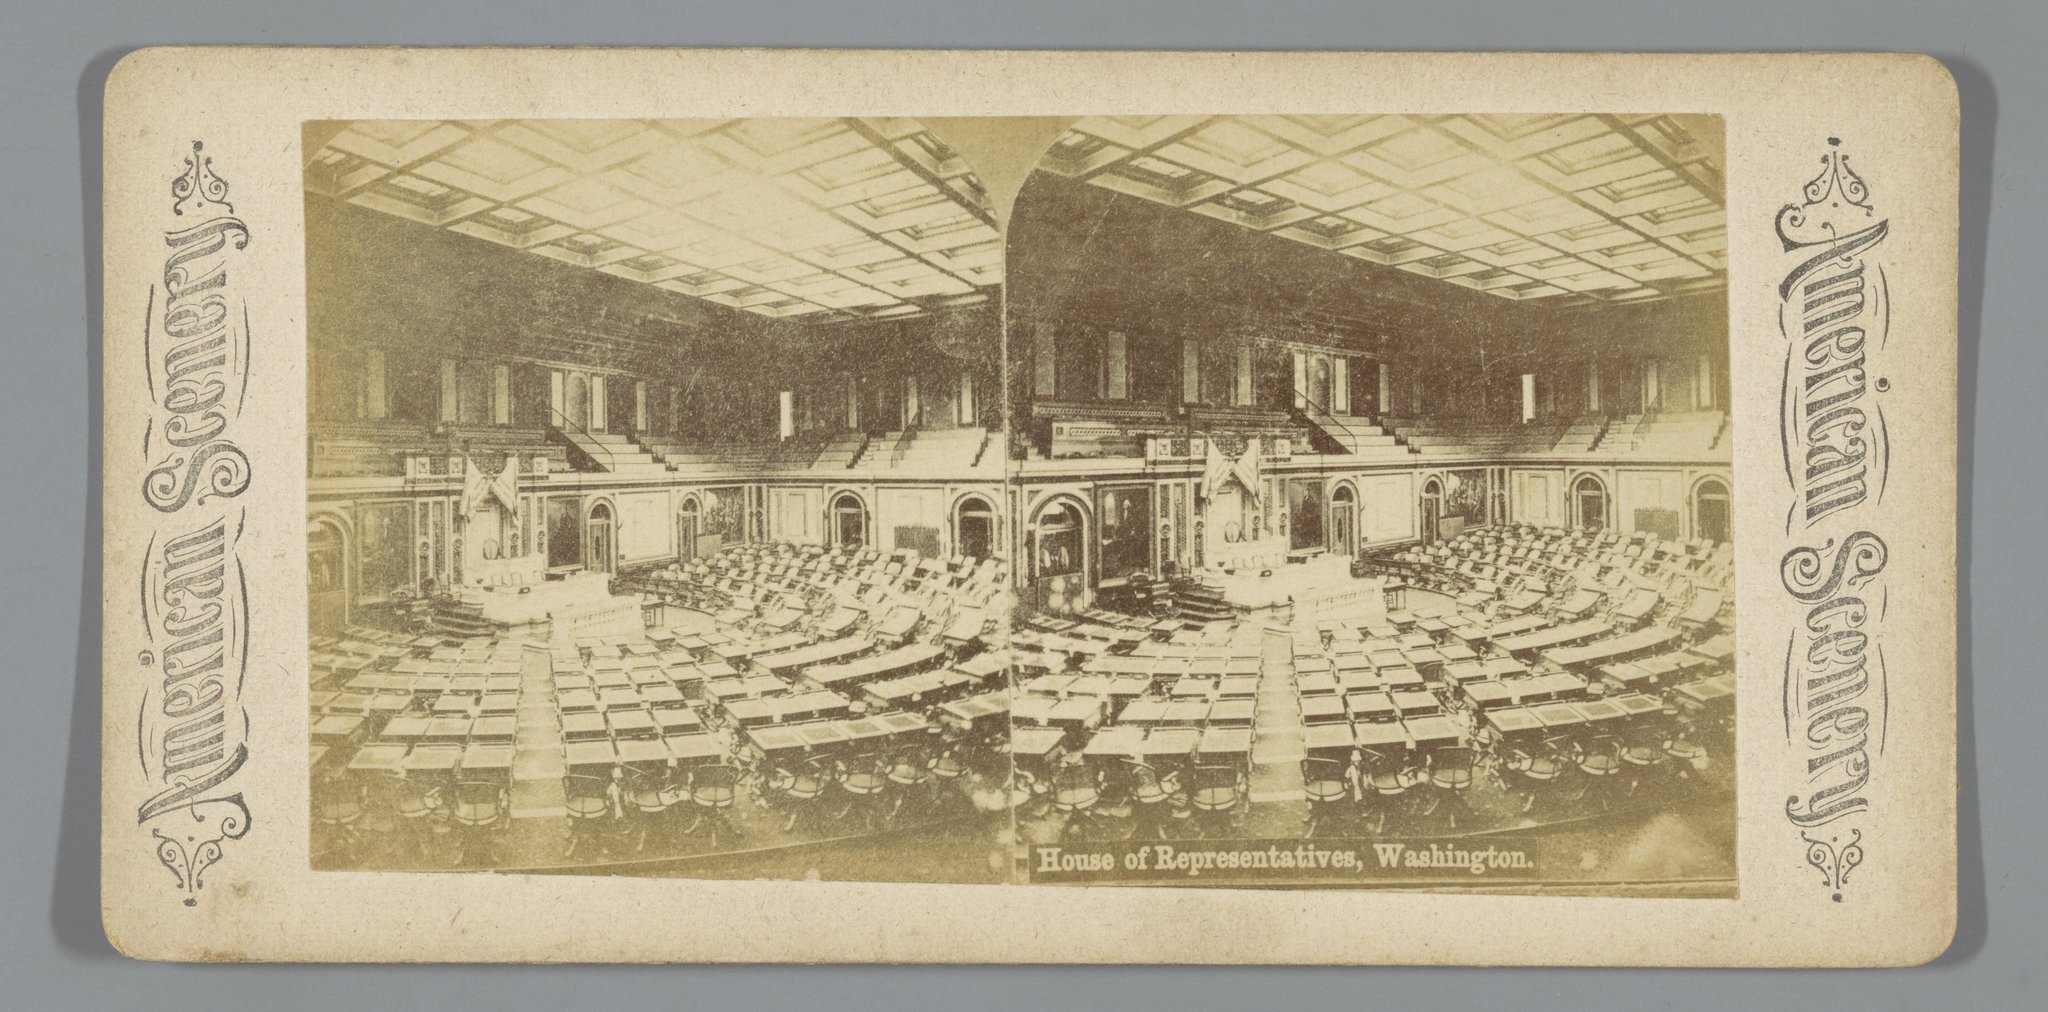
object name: stereograph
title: American Scenery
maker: Anonymous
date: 1868-1890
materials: cardboard, paper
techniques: albumen print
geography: washington d.c.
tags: court building